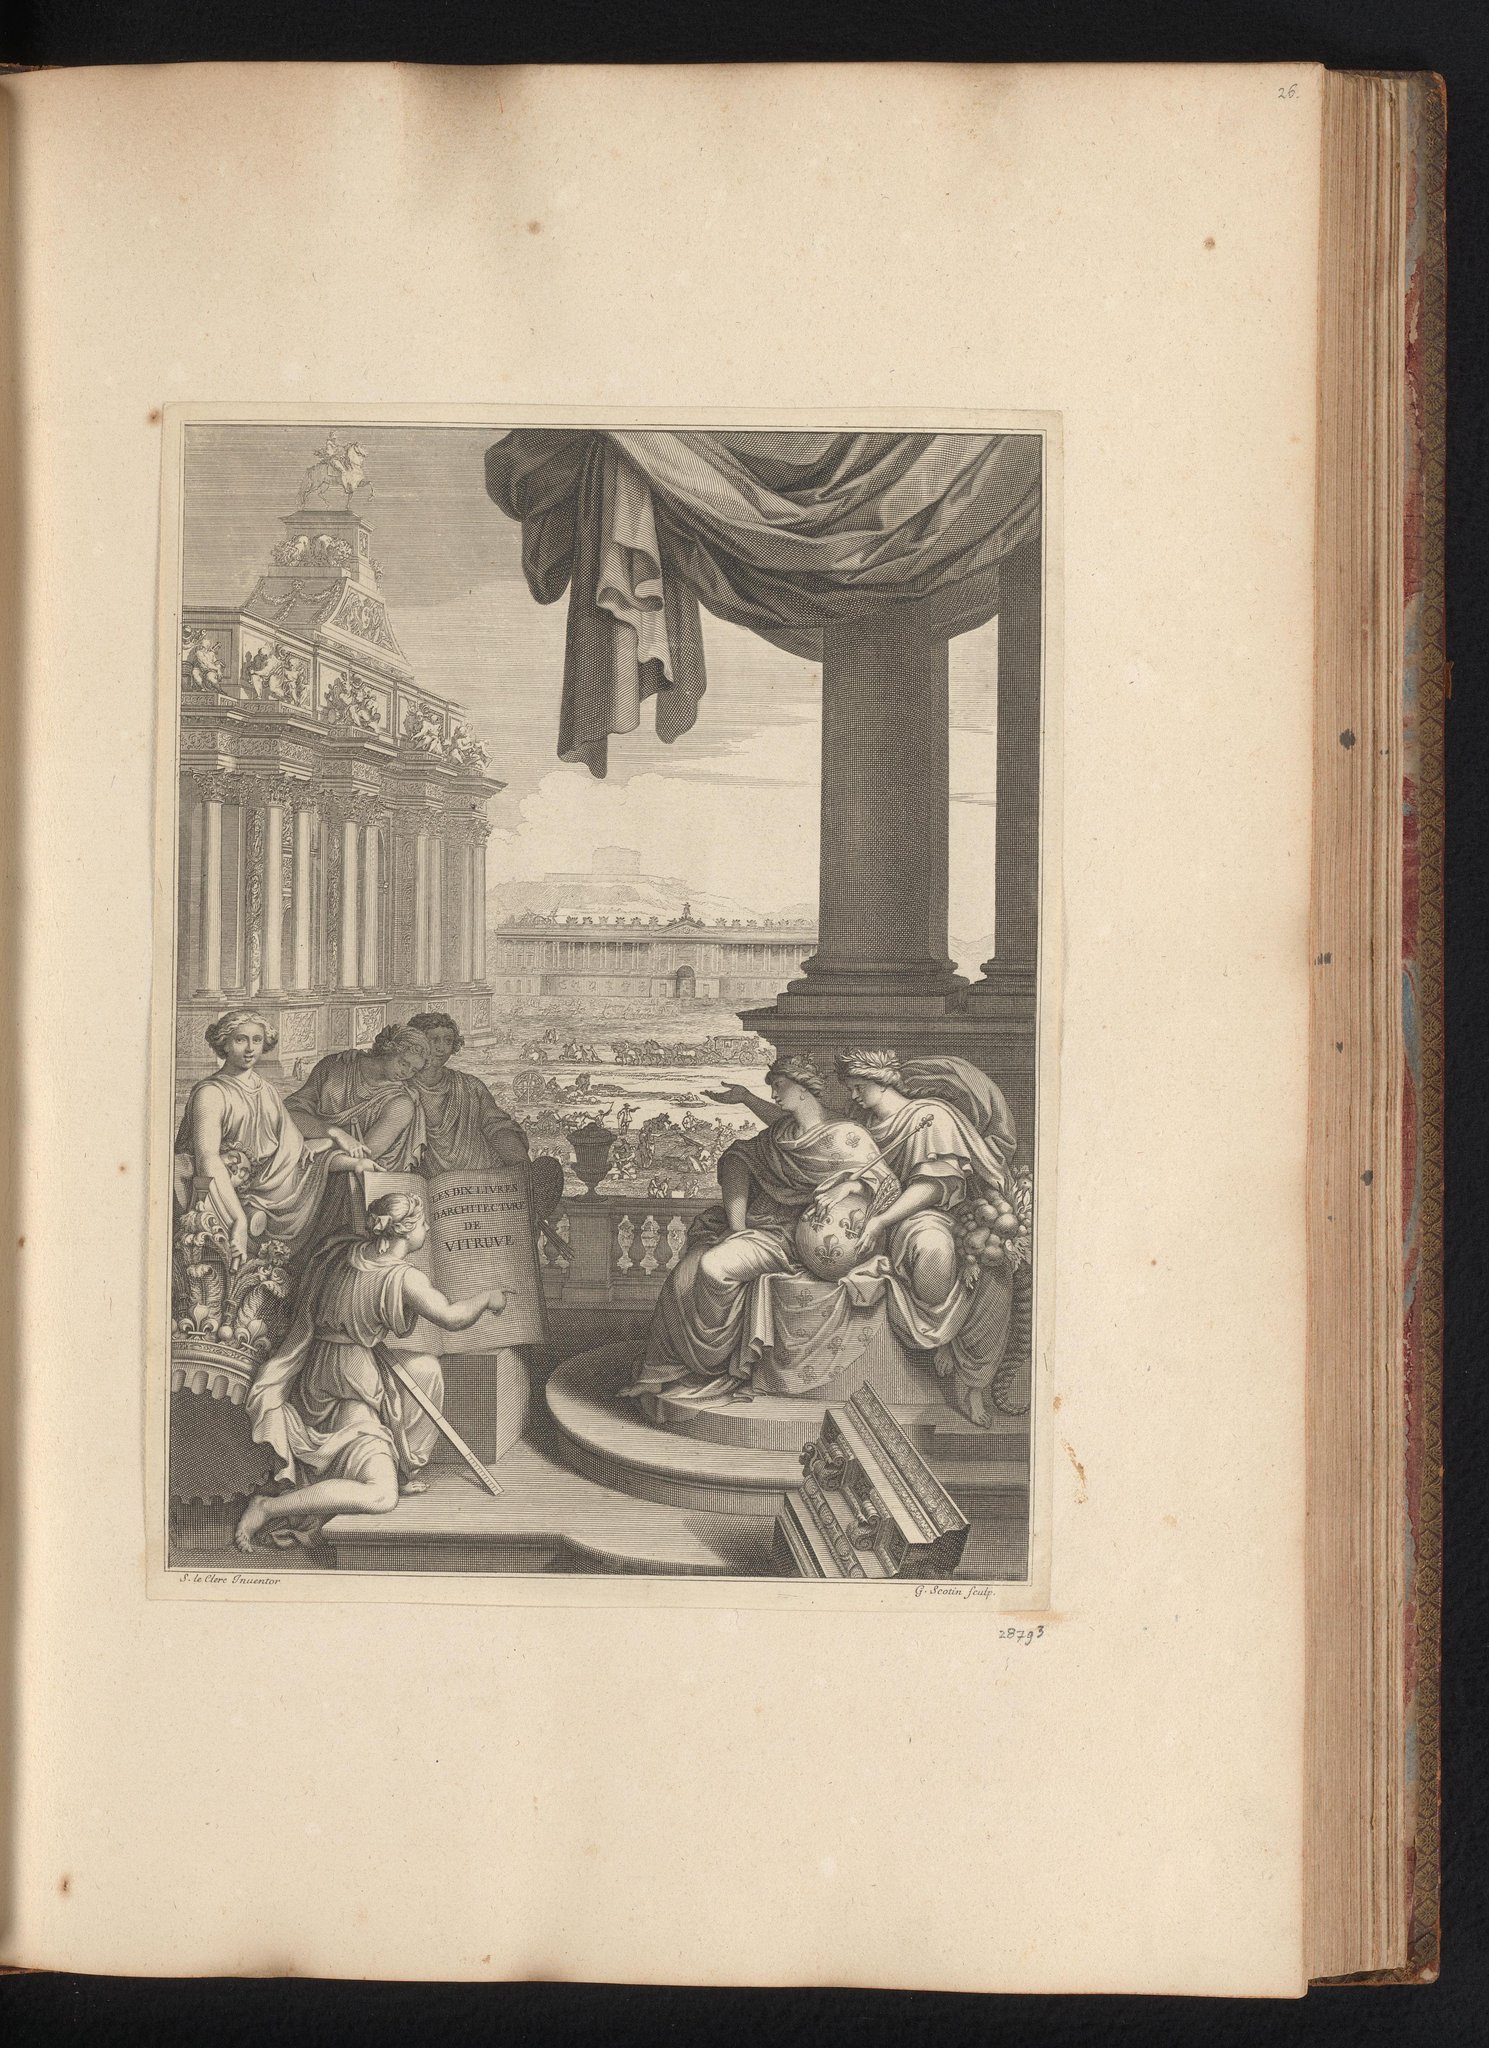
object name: titelblad, titelpagina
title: Personificaties van Frankrijk, de architectuur en de kunsten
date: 1673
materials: paper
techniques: engraving, etching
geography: paris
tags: the liberal arts, 'artes liberales', personifications of countries, nations, states, districts, etc., temple, shrine ~ roman religion, 'architectura', symbolic representations, allegories and emblems ~ architecture; 'architettura' (ripa)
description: Titelpagina voor: Perrault, Claude. Les dix livres d'architecture de Vitruve. Parijs: Jean-Baptiste Coignard, 1673.